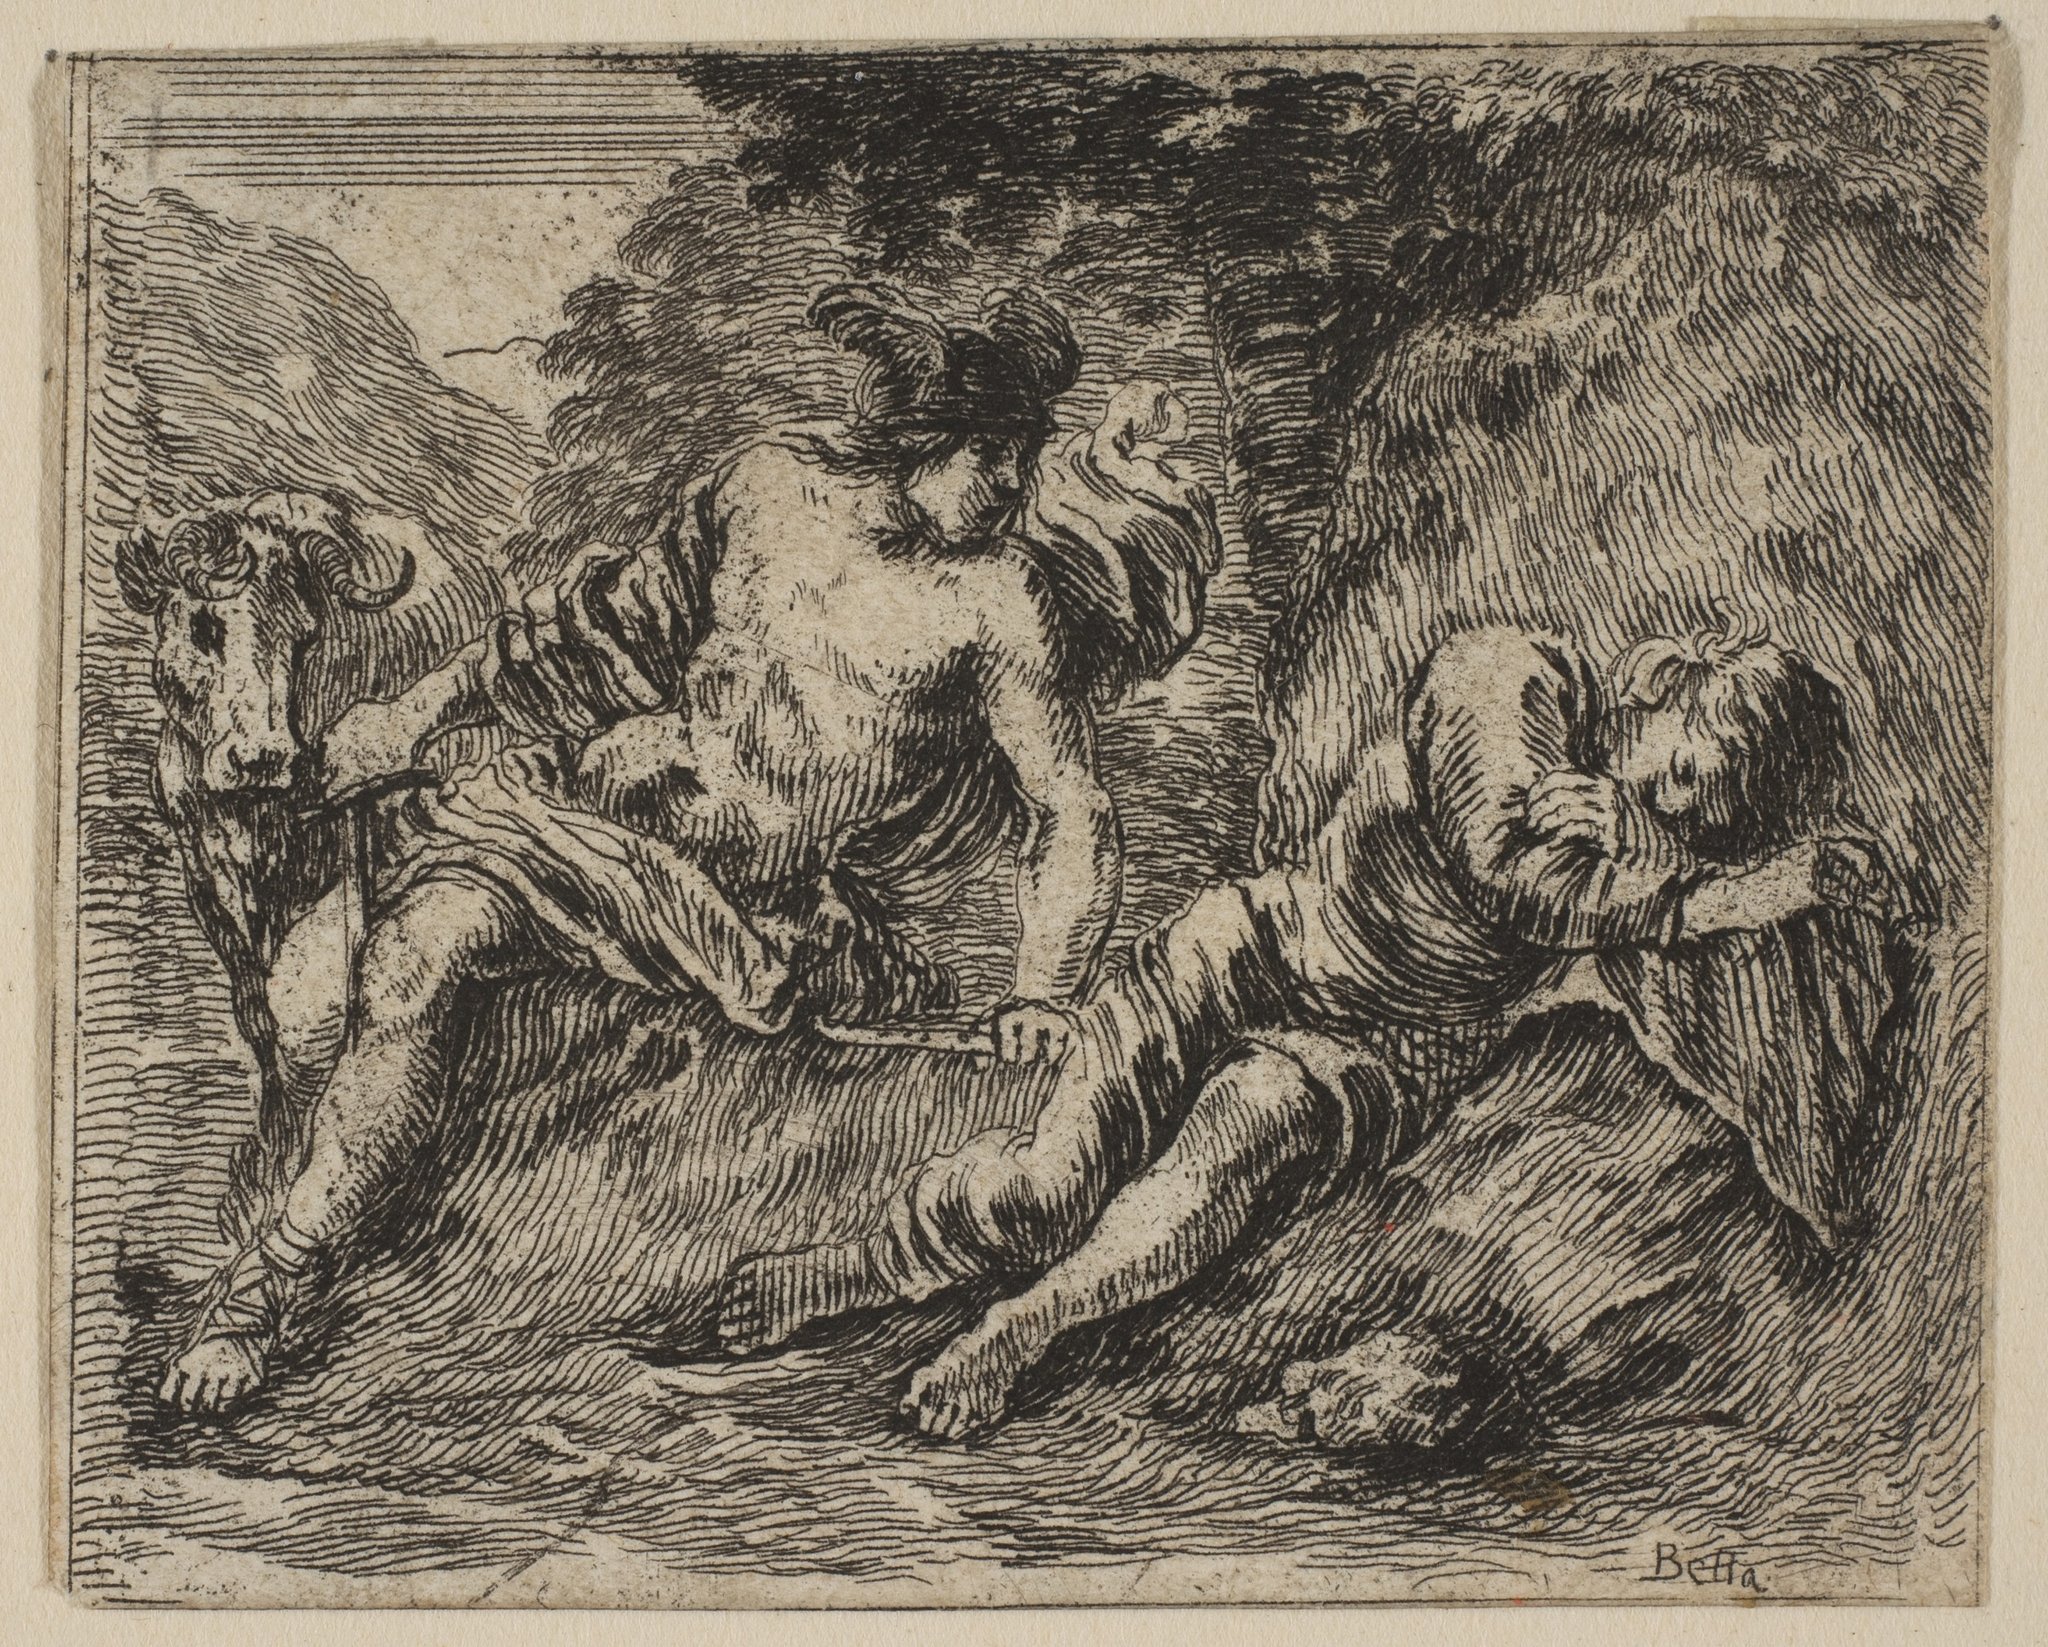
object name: print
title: Mercury and Argus, from 'Game of Mythology' (Jeu de la Mythologie)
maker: stefano della bella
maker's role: artist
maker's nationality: italian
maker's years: 1610-1664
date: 1644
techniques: etching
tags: sleeping,mercury,cows